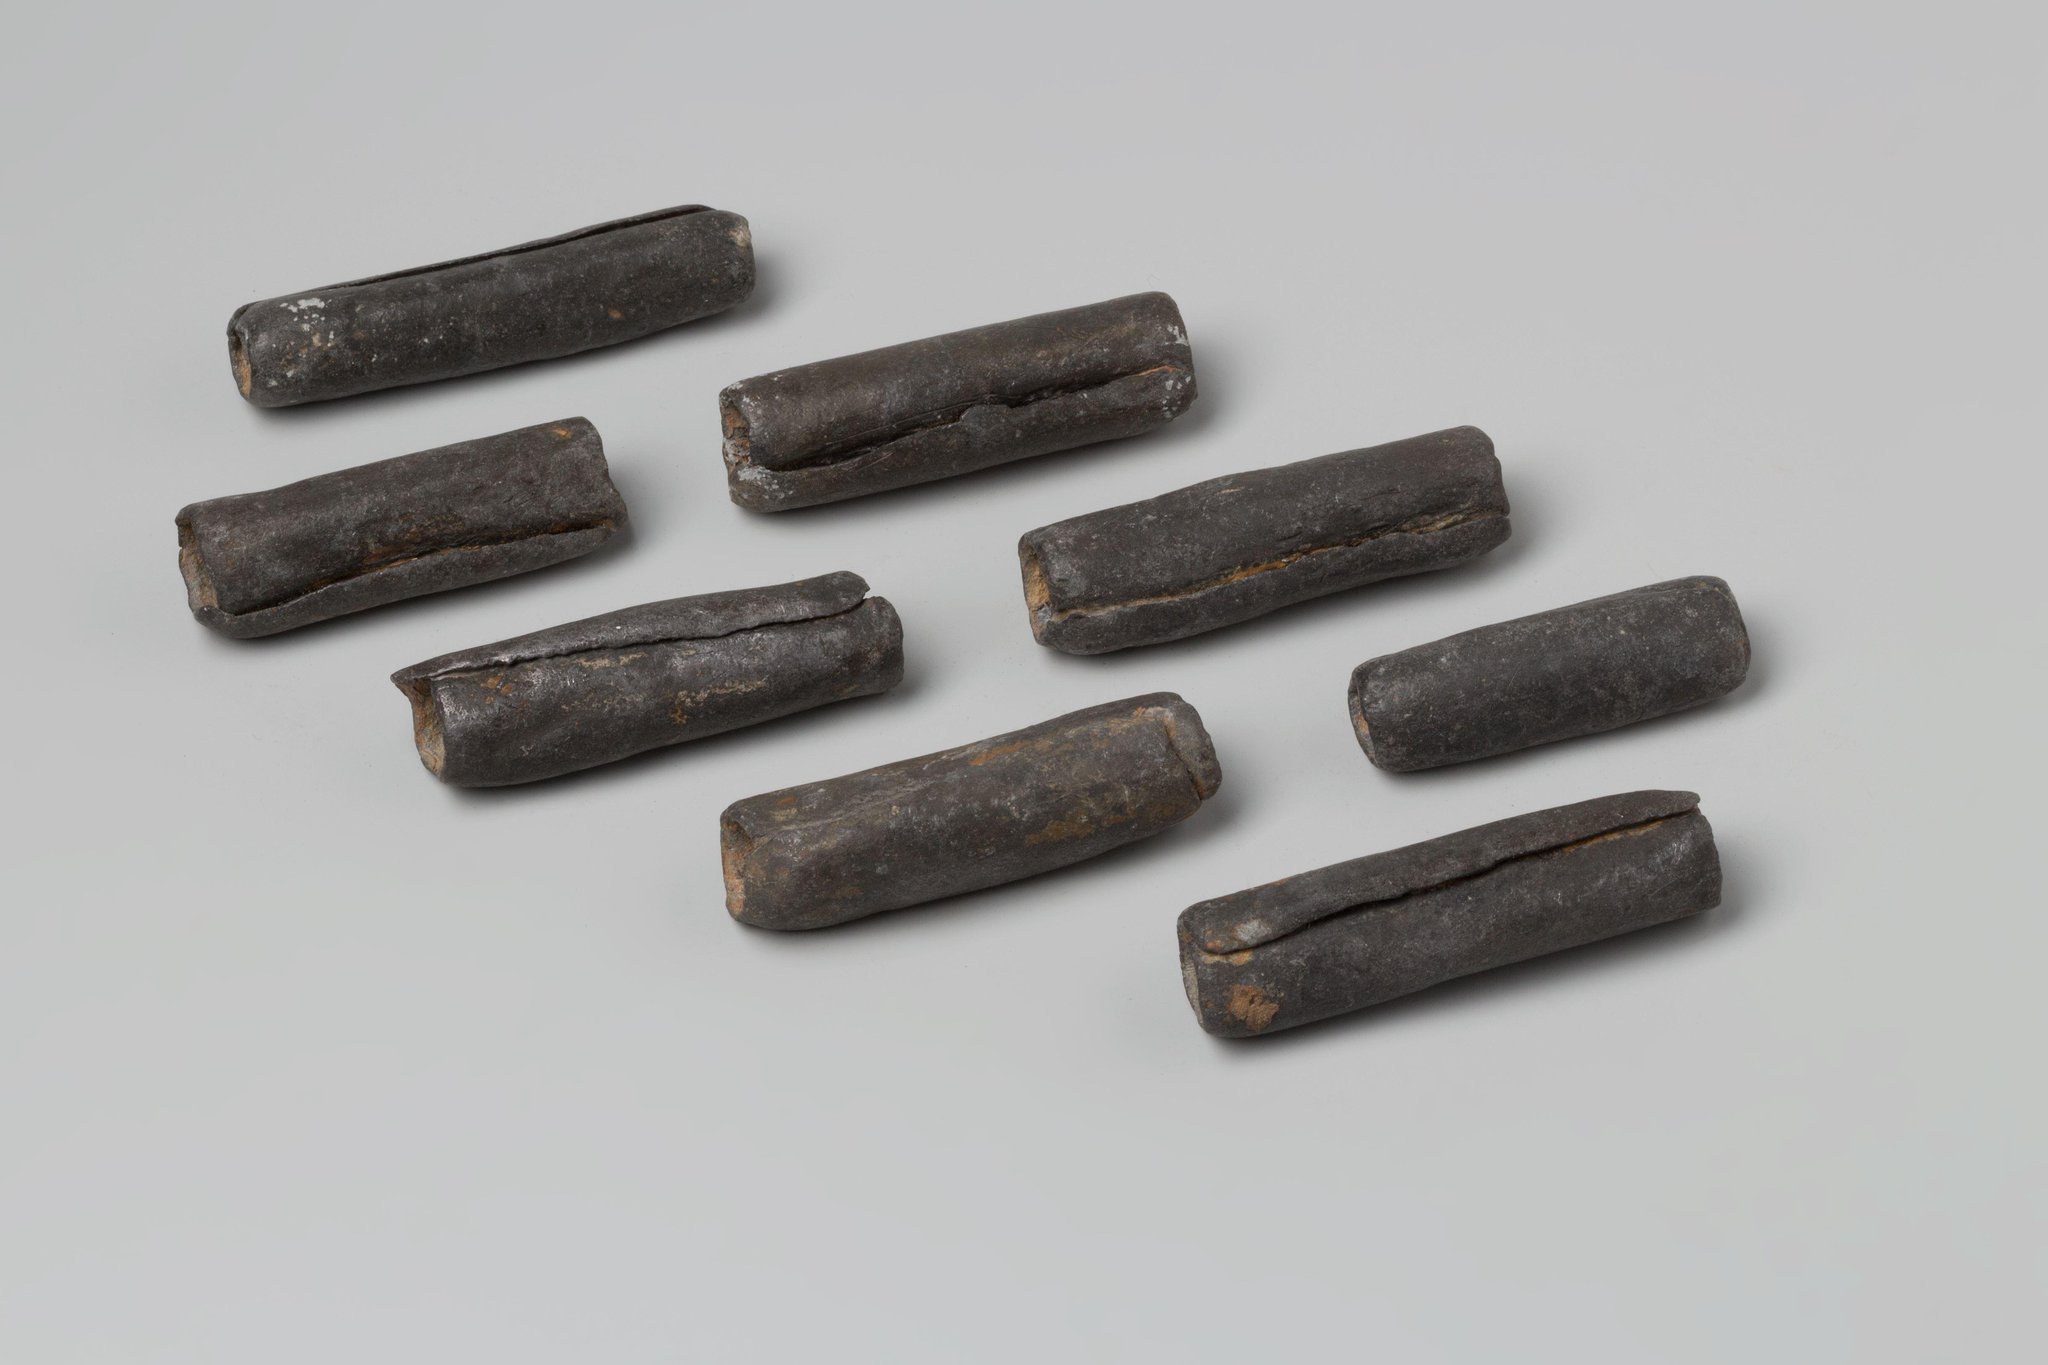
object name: lead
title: Loden rol uit het wrak van de Oost-Indiëvaarder 't Vliegend Hart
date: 1700-1735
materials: lead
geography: middelburg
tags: 't vliegend hart (schip), verenigde oostindische compagnie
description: Deze loden buisjes zijn vermoedelijk afkomstig van visnetten ofwel op TVliegend Hart zelf ofwel van vissers die hun netten aan het wrak verloren.